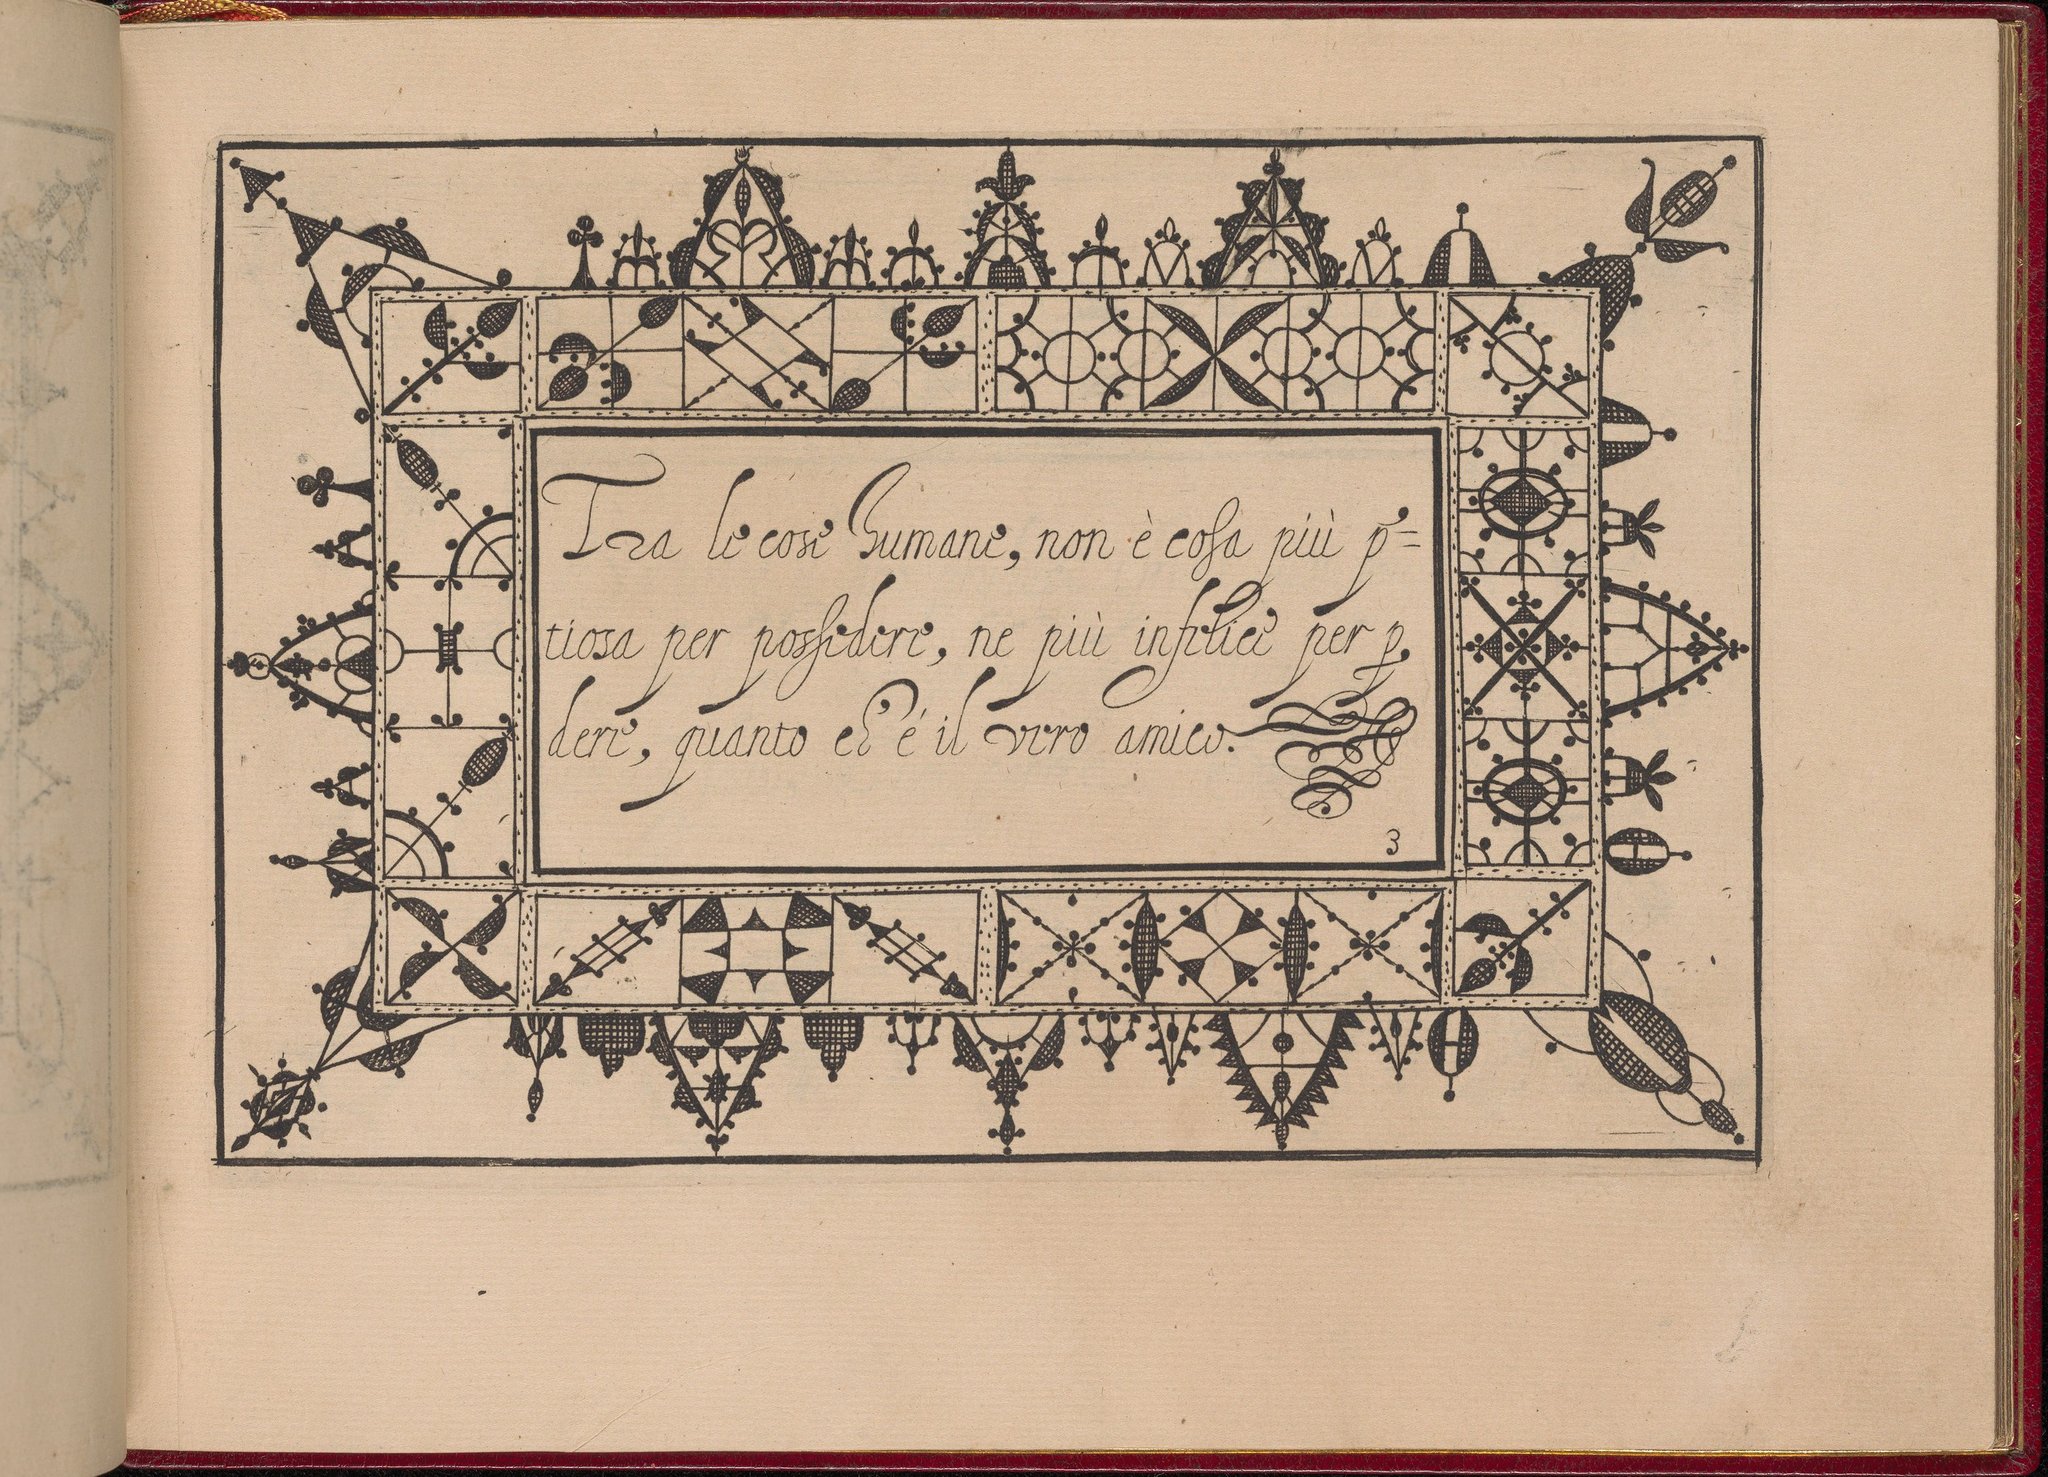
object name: book print ornament architecture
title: Ghirlanda: Di sei vaghi fiori scielti da piu famosi Giardini d'Italia, page 11 (recto)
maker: pietro paulo tozzi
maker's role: designer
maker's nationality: italian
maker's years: 1593-1628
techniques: drawing, etching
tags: ornament